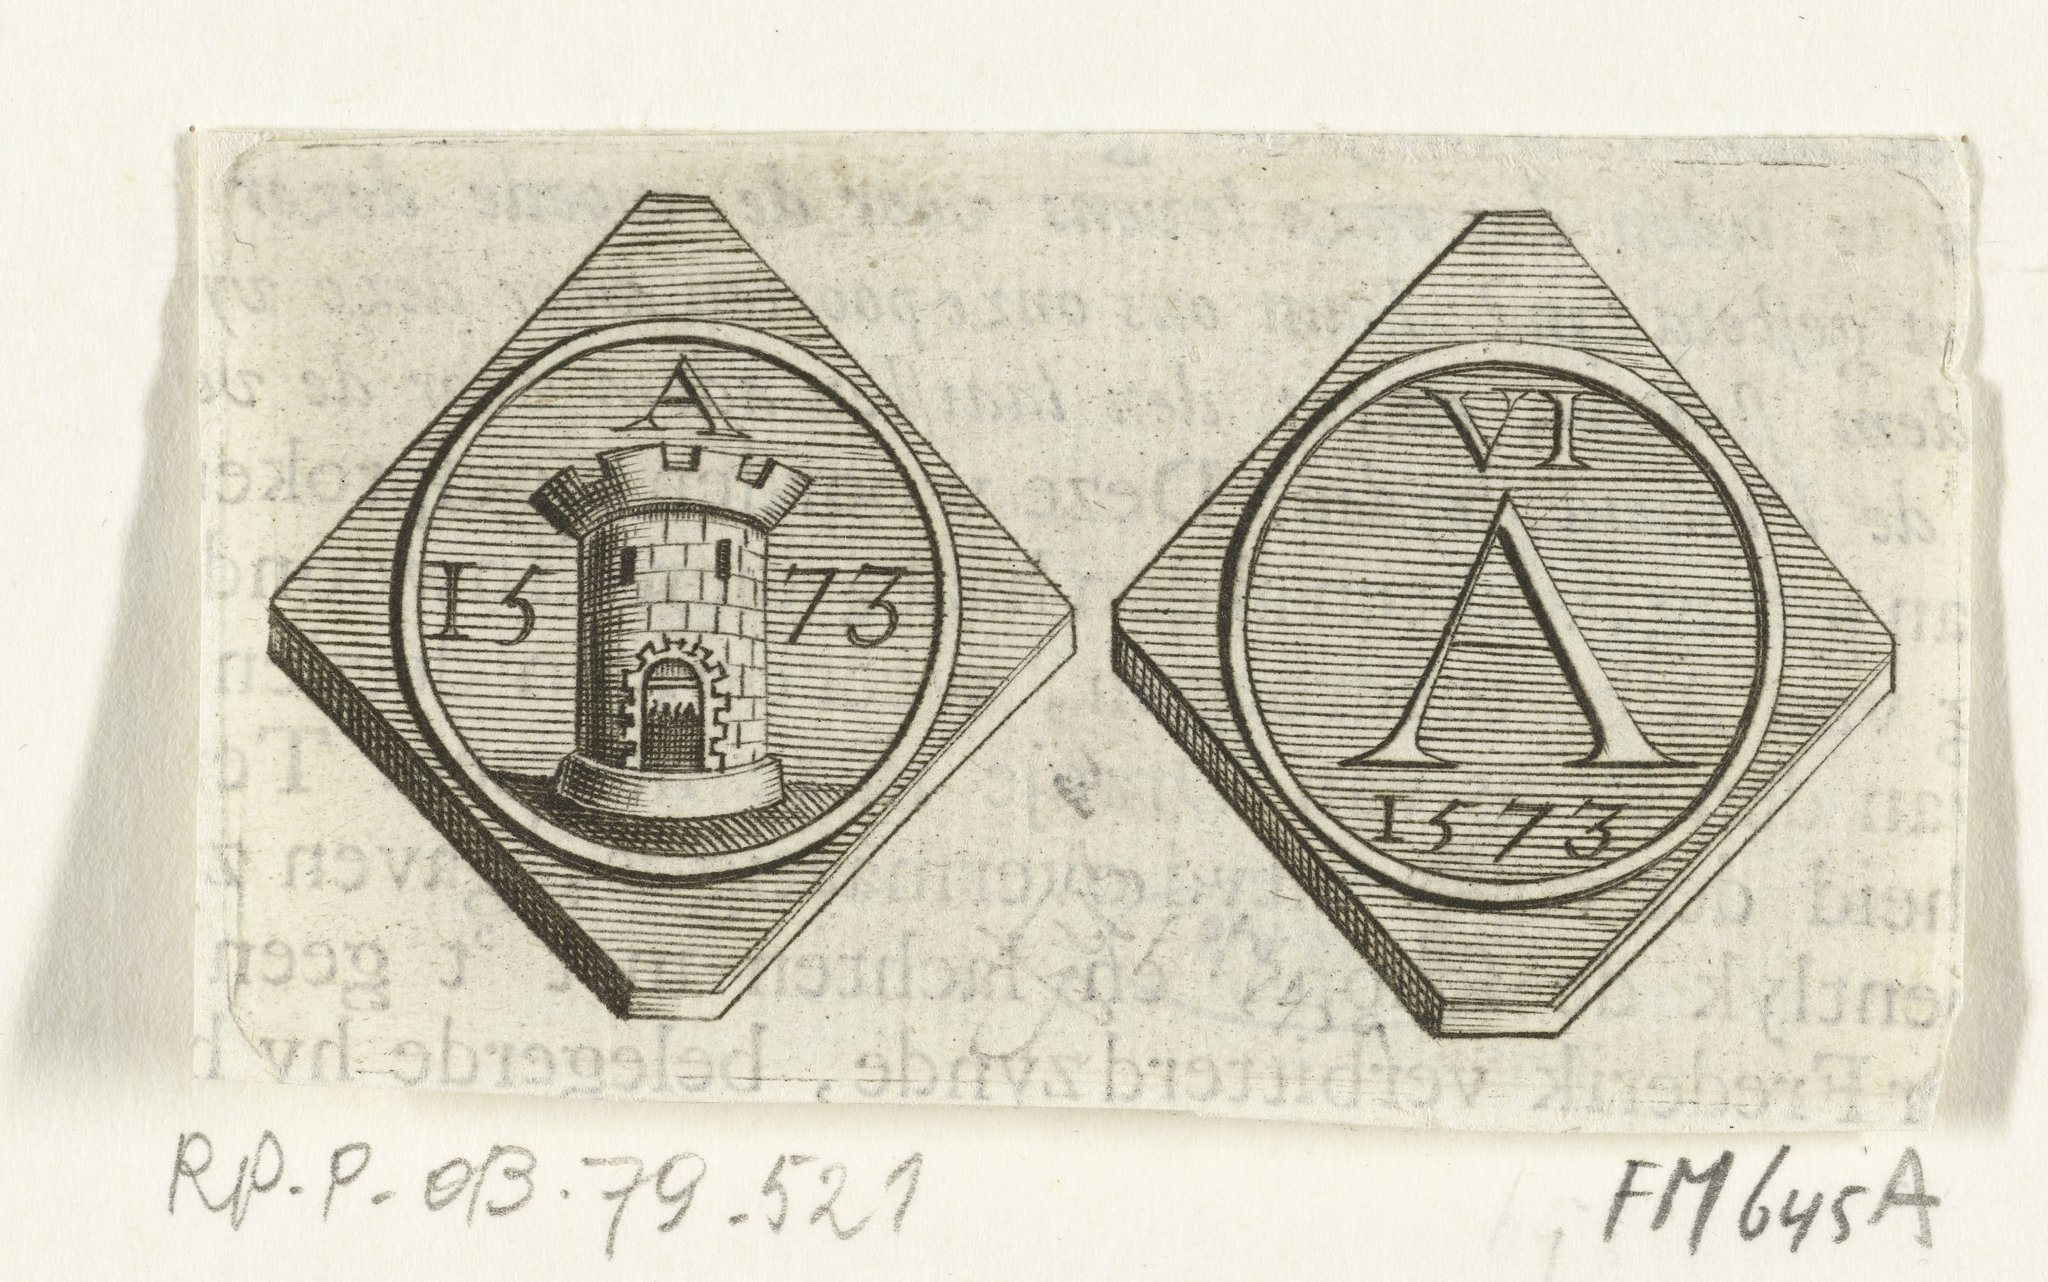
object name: historical object representation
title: Noodgeld uit het beleg van Alkmaar, 1573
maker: Anonymous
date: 1650-1749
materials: paper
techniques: engraving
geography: northern netherlands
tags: coin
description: Voor- en keerzijde van noodgeld in omloop gebracht tijdens het beleg van Alkmaar, 1573. Bedrukt op de achterzijde met tekst in het Nederlands.